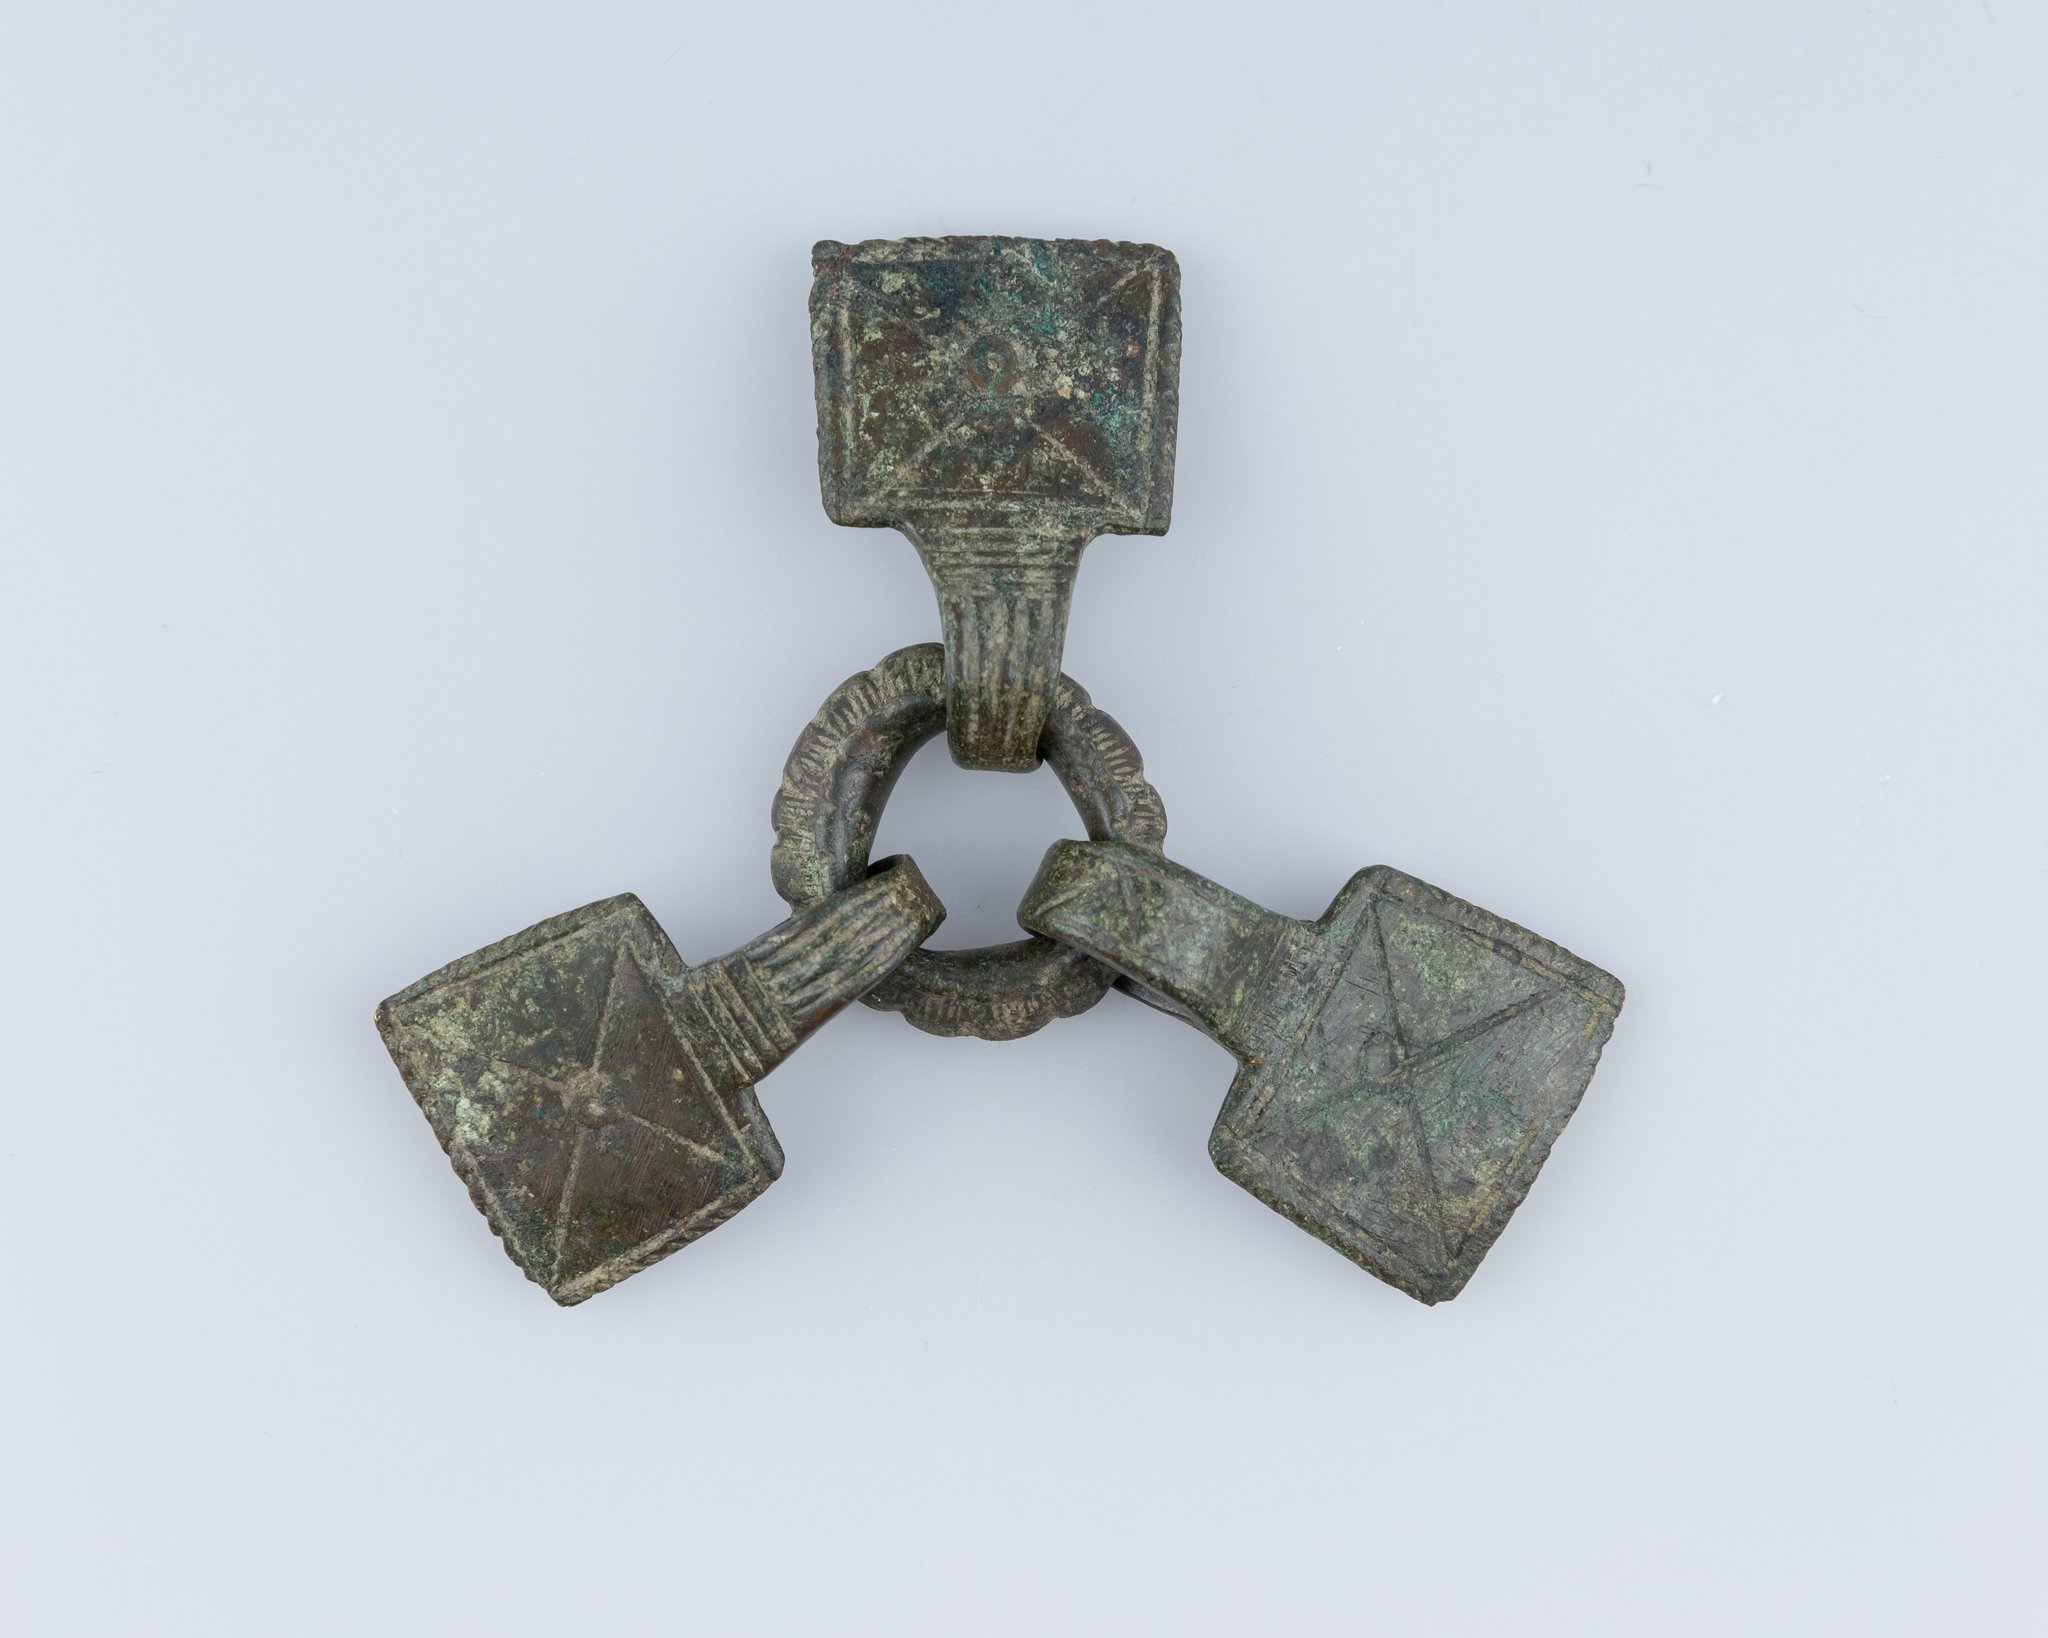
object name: harness ornament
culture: irish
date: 1501-1700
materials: bronze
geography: ireland